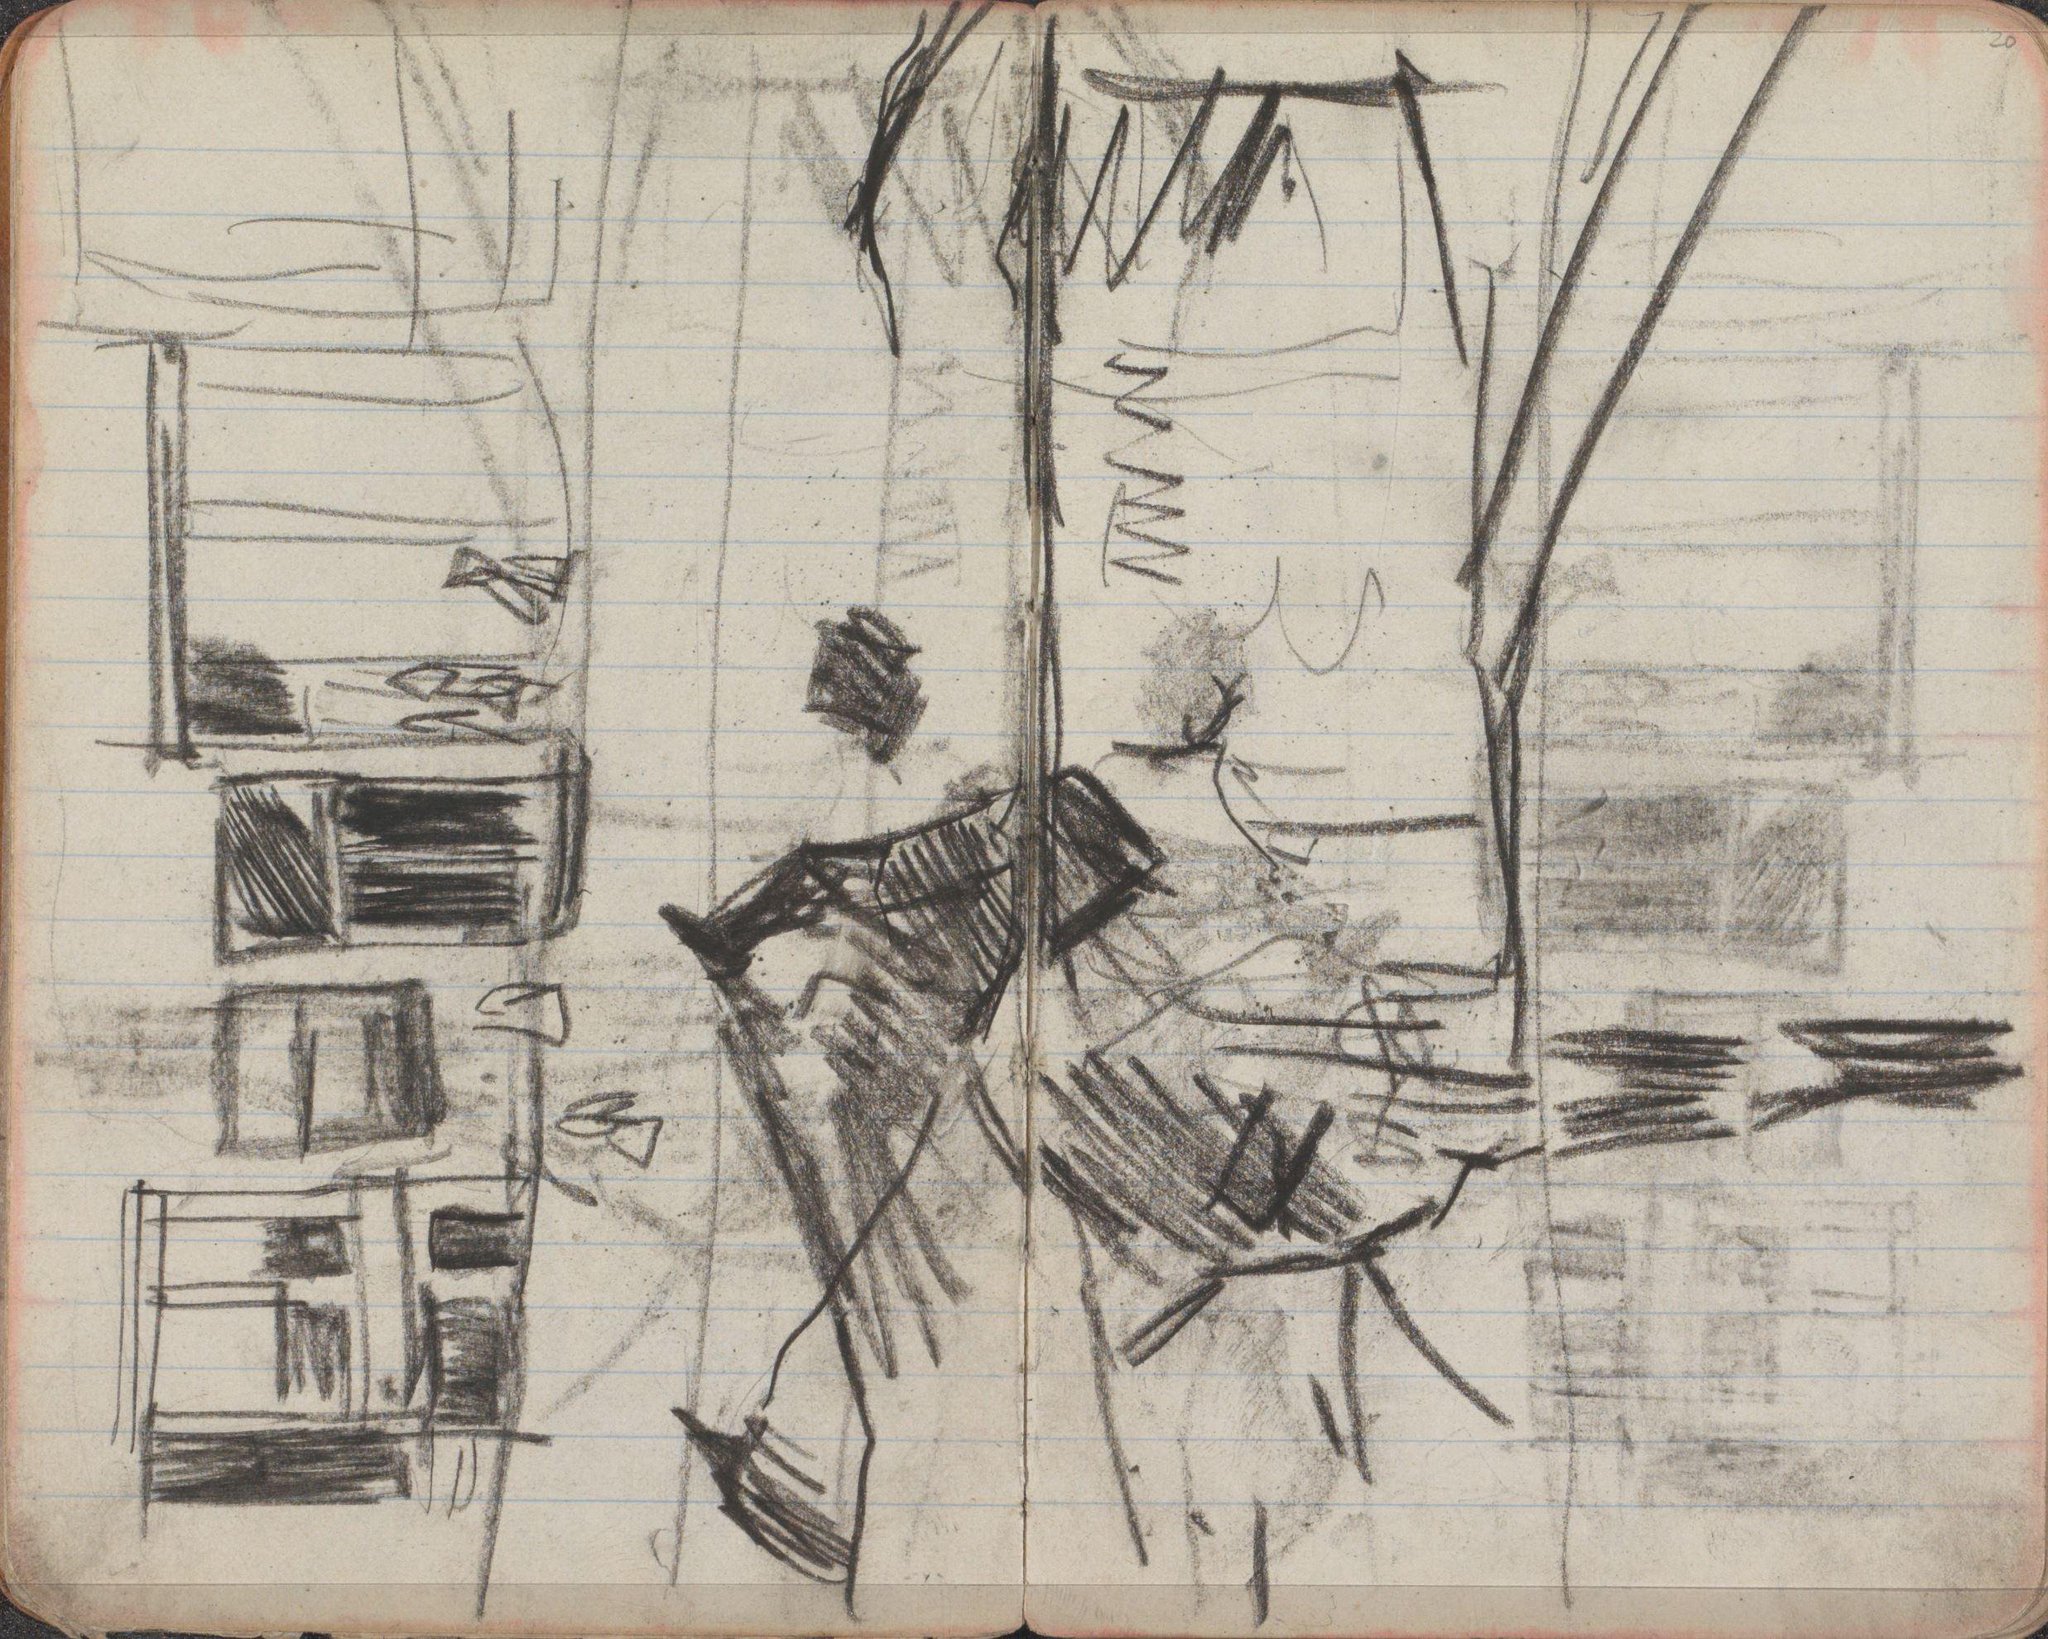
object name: sketchbook leaf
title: Paarden aan de Lauriergracht te Amsterdam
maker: george hendrik breitner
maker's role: draughtsman, painter, print maker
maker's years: 1857-1923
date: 1892-1900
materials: chalk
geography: amsterdam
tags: canals, waters (in city), horse, civic architecture; edifices; dwellings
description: Pagina 19 en pagina 20 uit een schetsboek met 38 bladen.